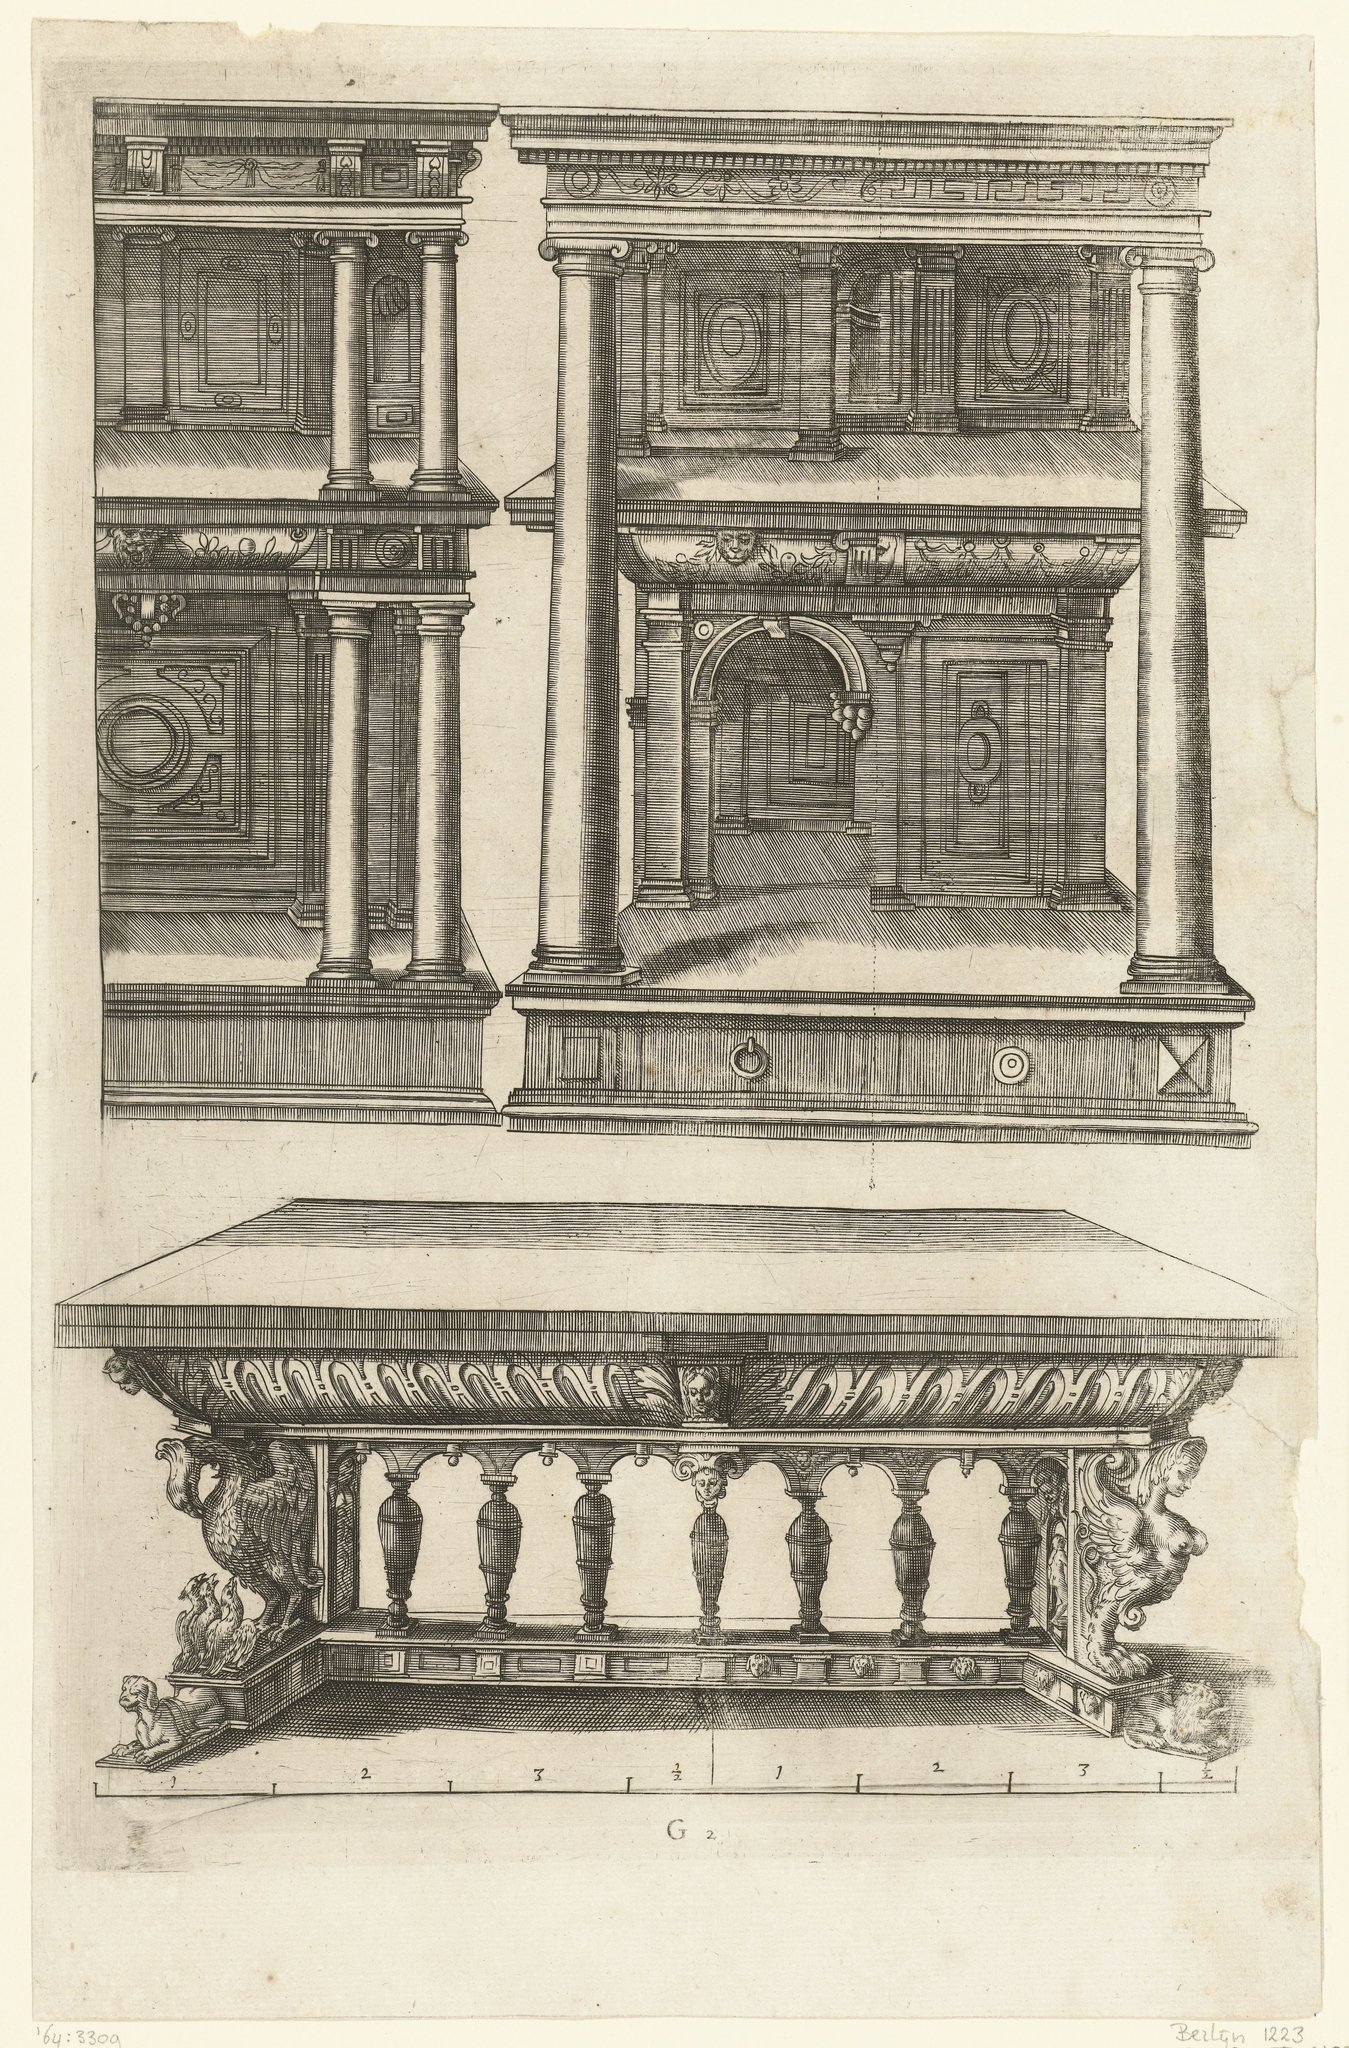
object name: ornament print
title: Twee buffetkasten en een tafel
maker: Anonymous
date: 1642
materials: paper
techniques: engraving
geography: amsterdam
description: De buffetkast linksboven is maar half te zien. De buffetkast rechtsboven toont een variant voor de rechterhelft. De poten van de tafel zijn verschillend gedecoreerd.